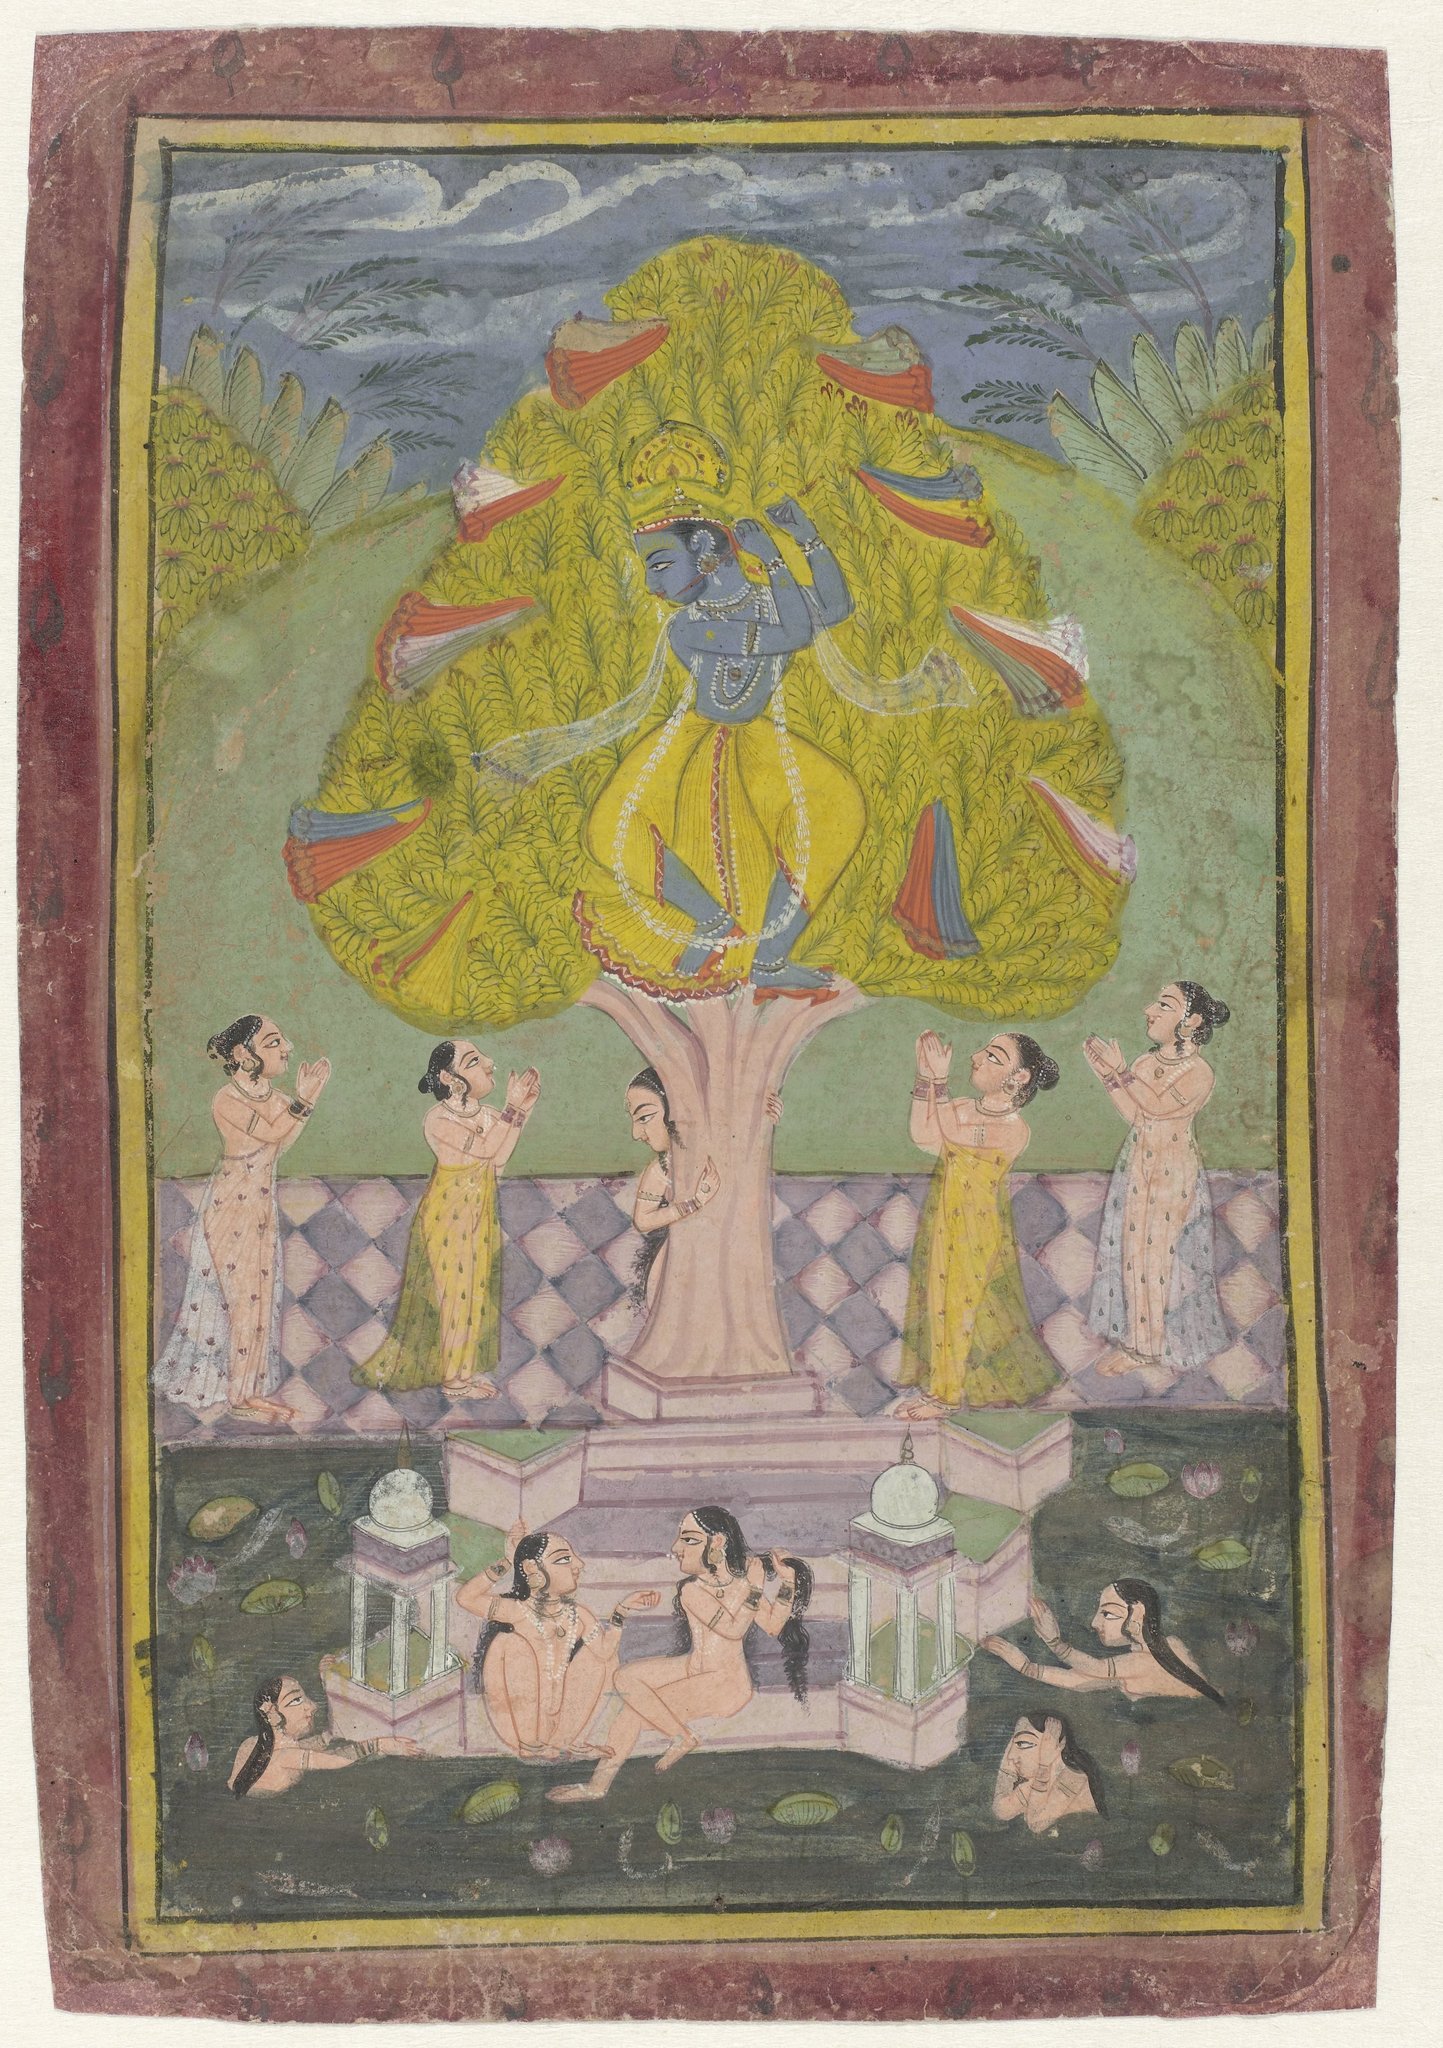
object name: indian miniature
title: Krishna Stealing the Clothes of Gopis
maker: Anonymous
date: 1780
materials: paper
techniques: brush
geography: bundi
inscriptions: inscription: ‘.’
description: Often loving and playful, the young cowherd is a cherished form of Krishna. In the centre of this bathing scene, a nude gopi (cowherd woman) conceals herself behind the tree. Four women with veils hastily wrapped around their bodies gesture imploringly towards Krishna. Krishna plays his flute in the treetop where the stolen garments sway in the wind.